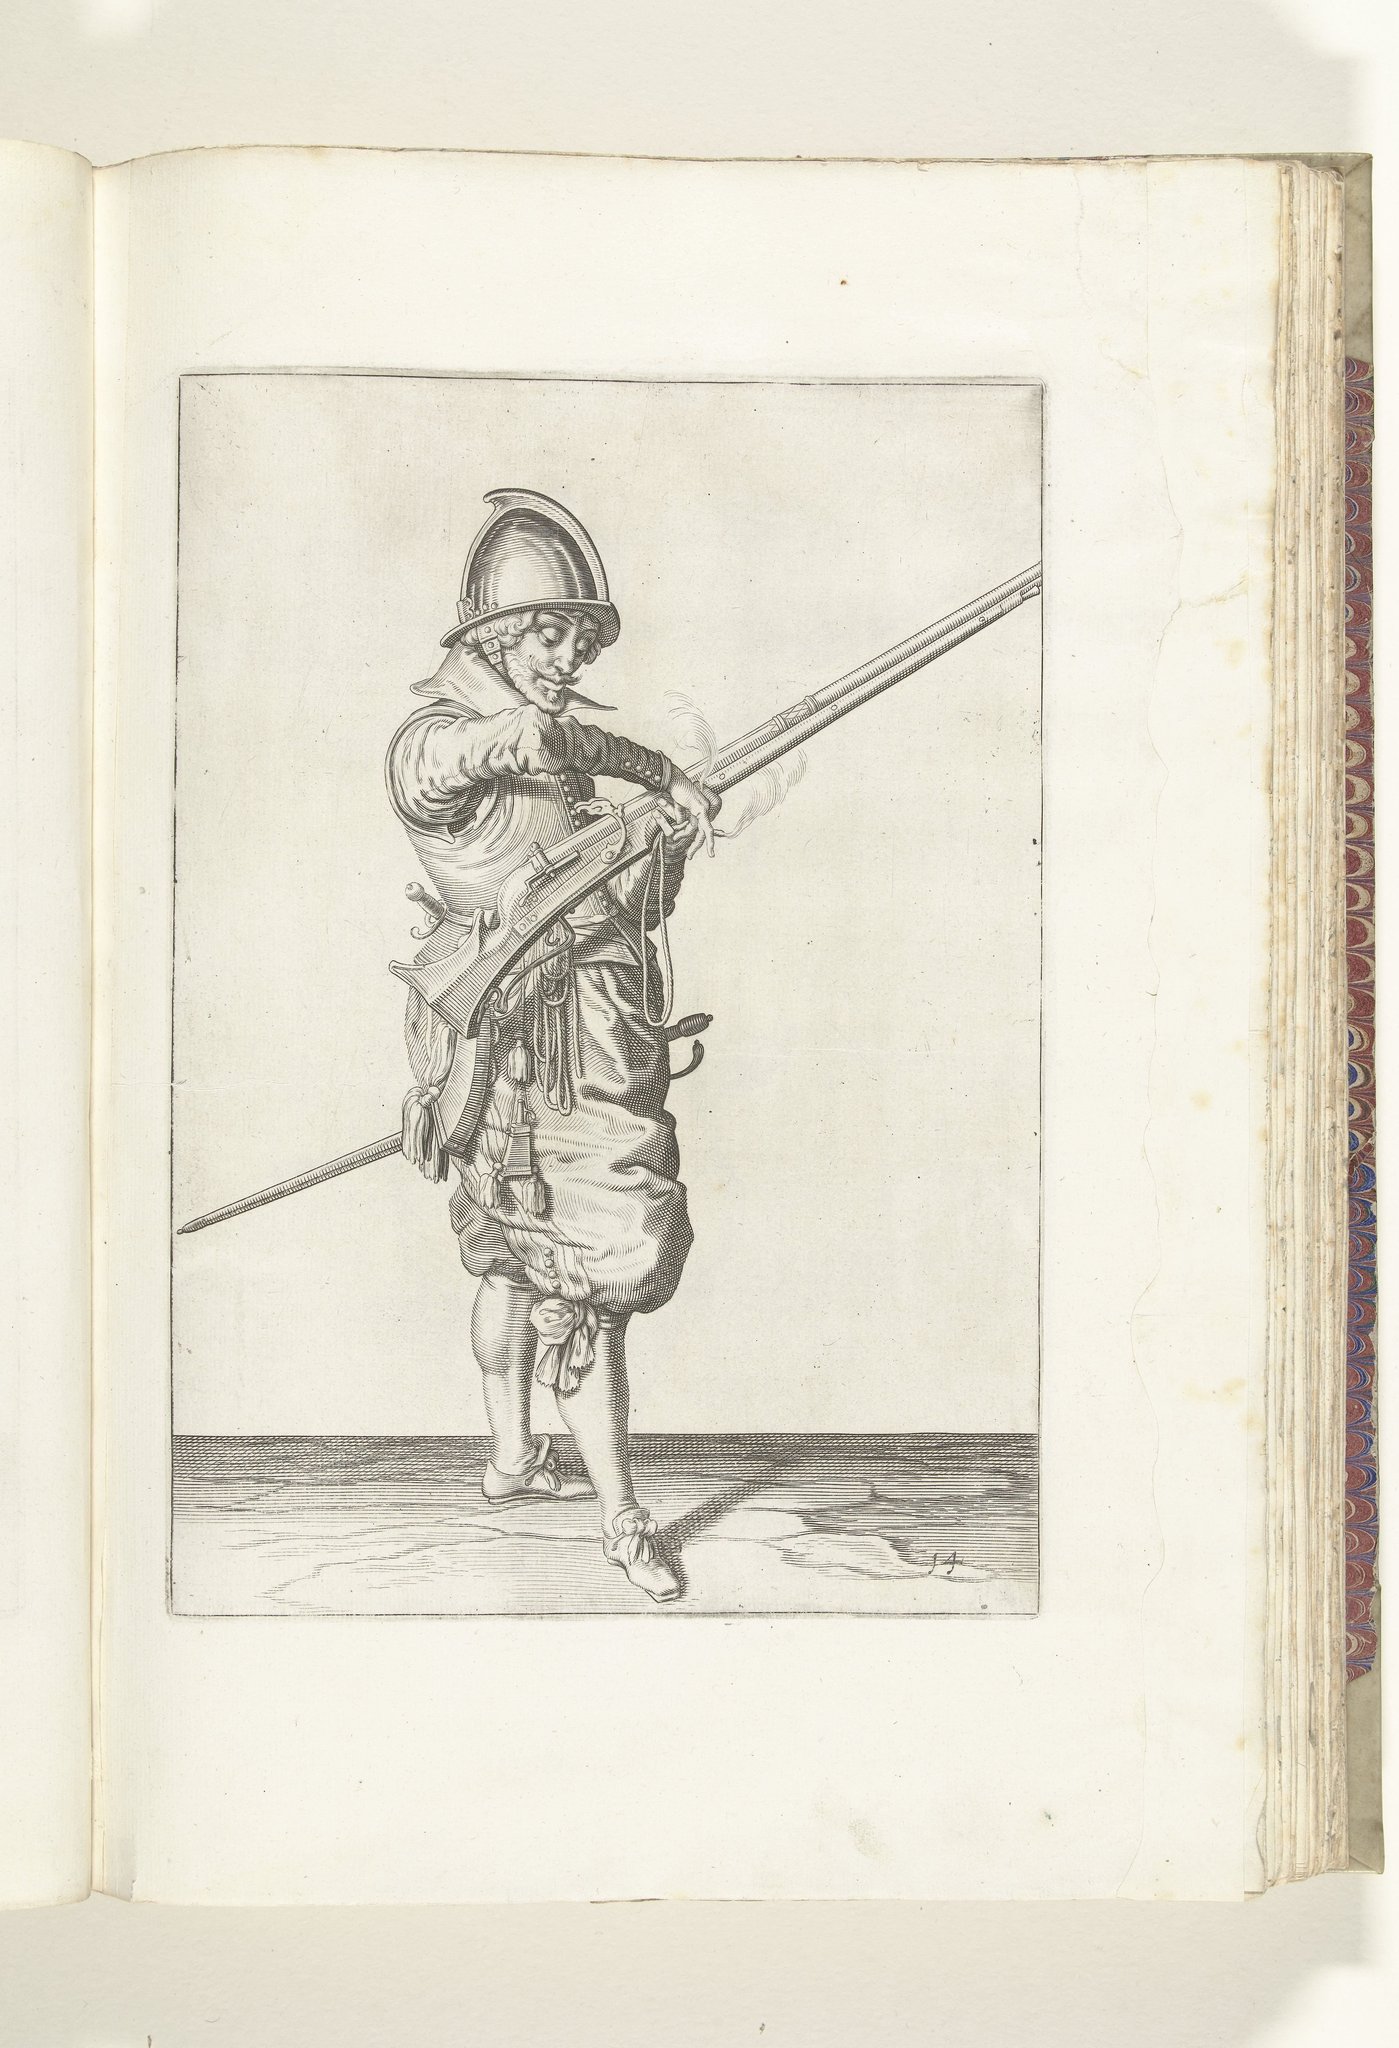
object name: print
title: Soldaat met een roer die zijn lont overbrengt van zijn rechter- naar zijn linkerhand (nr. 14), ca. 1600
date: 1597-1607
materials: paper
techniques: engraving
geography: amsterdam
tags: maurice (prince of orange), handling of weapons ~ military training, weapons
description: Een soldaat, ten voeten uit, naar rechts, die een roer (een bepaald type vuurwapen) met zijn linkerhand vasthoudt (nr. 14), ca. 1600. De brandende lont in zijn rechterhand brengt hij over naar zijn linkerhand. Plaat 14 in de instructies voor het hanteren van de roer. Onderdeel van de illustraties in: J. de Gheyn, Wapenhandelinghe van Roers Musquetten ende spiessen, Amsterdam, 1608. Krijgswezen rond 1600.